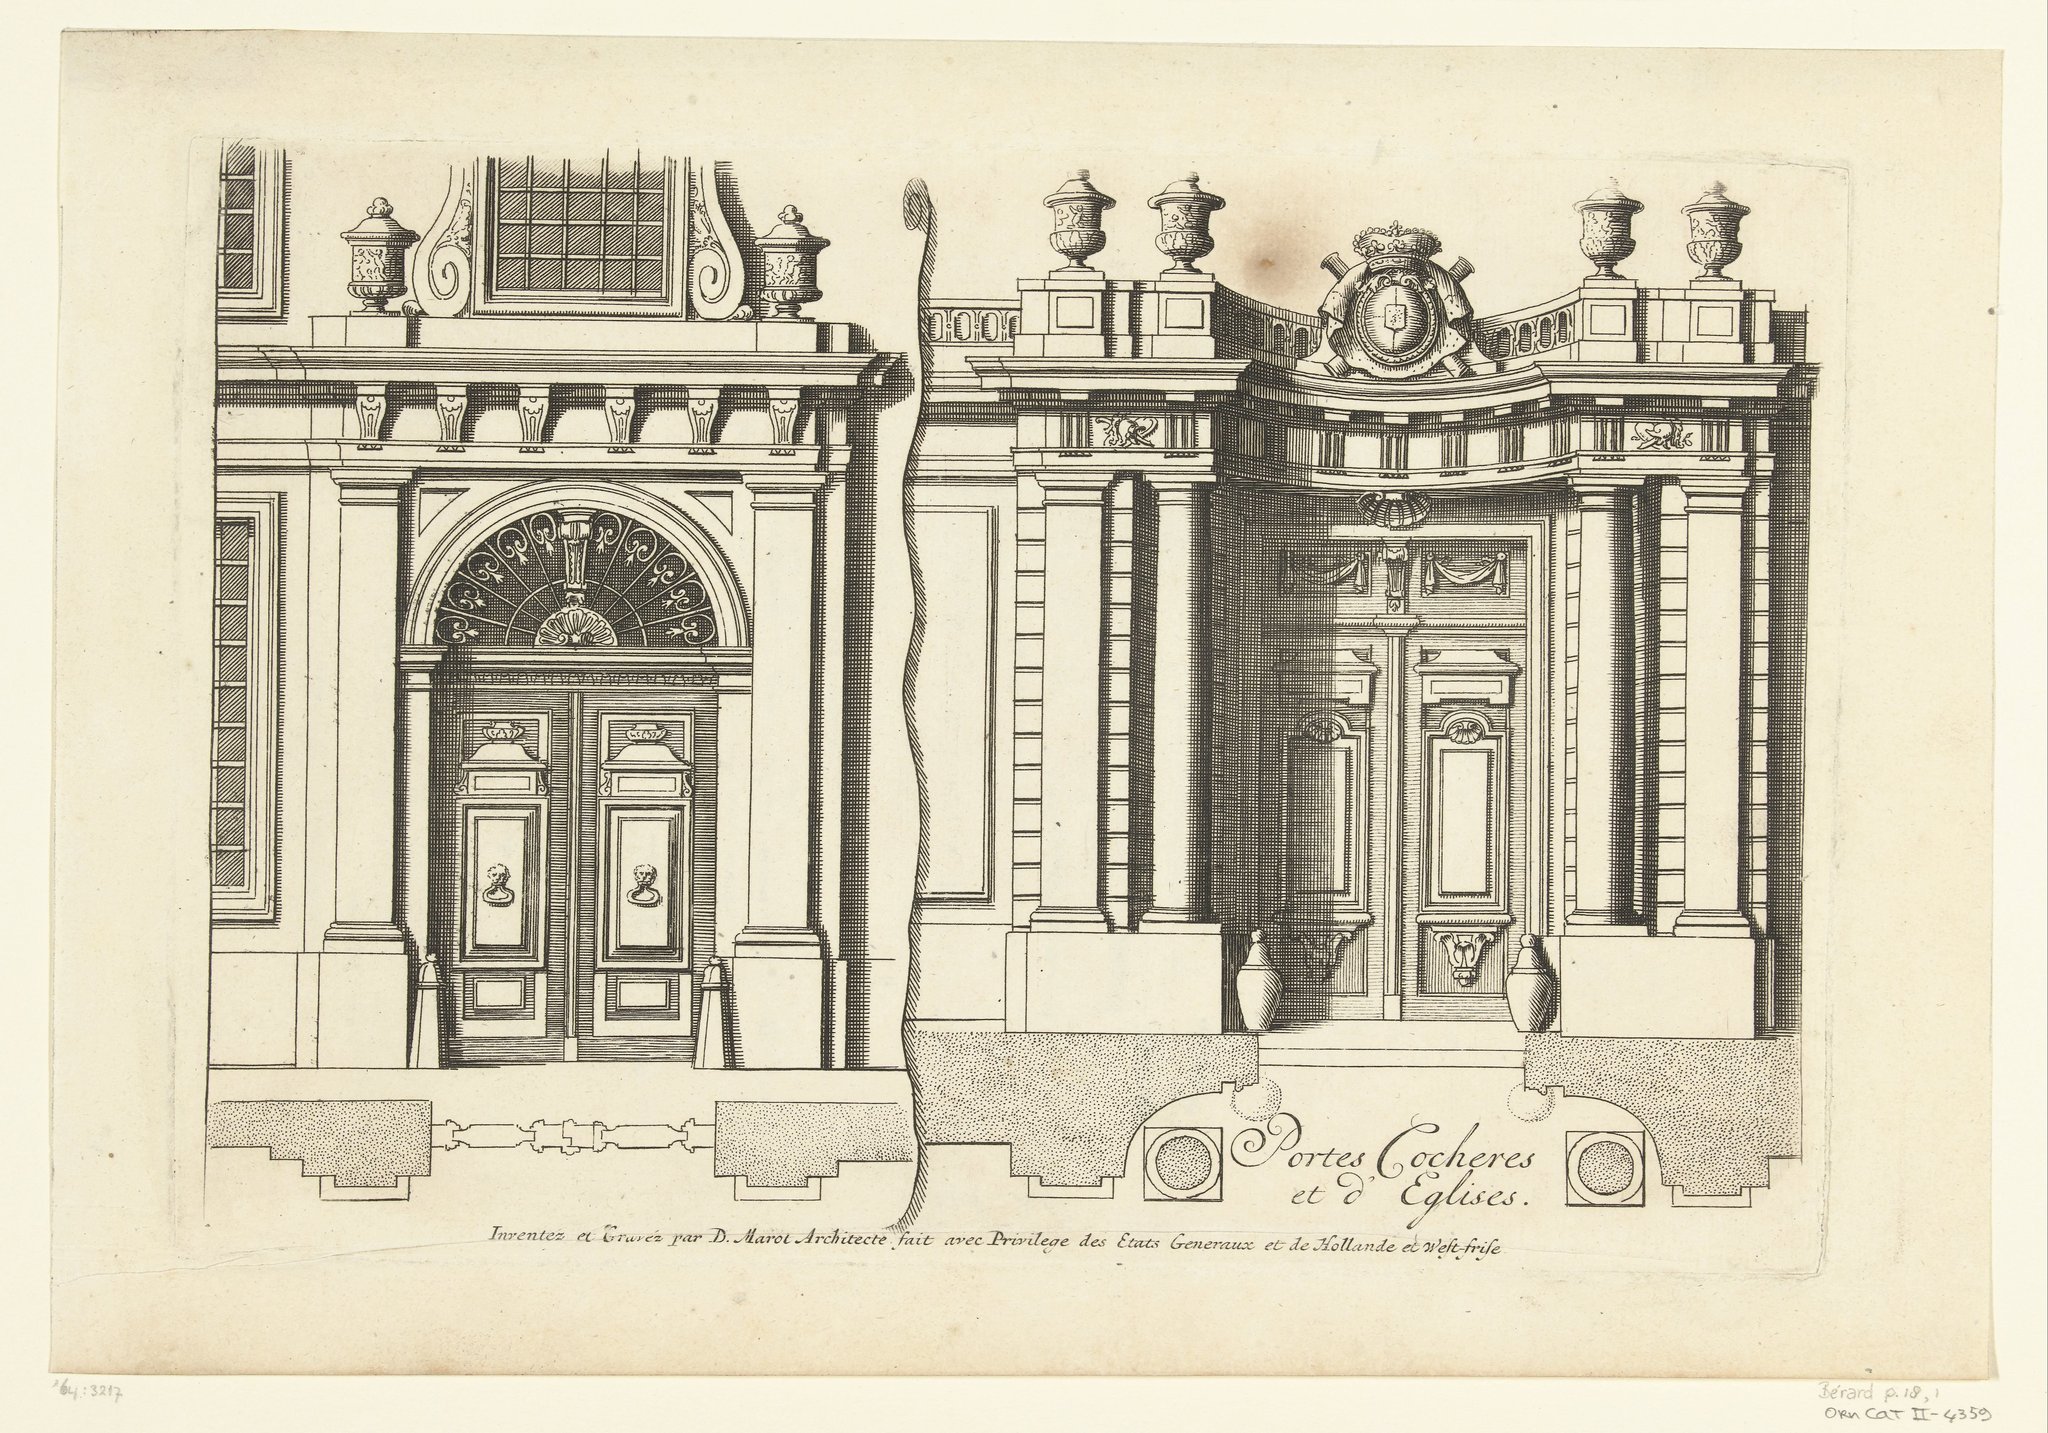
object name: titelblad, titelpagina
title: Portes Cocheres et d'Eglises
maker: daniël marot (i)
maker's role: draughtsman, print maker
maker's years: 1661-1752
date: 1673-1752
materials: paper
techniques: etching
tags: balustrade, door, parts of church exterior and annexes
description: Het portiek van het binnenhof rechts is bekroond met een wapenschild en vazen. Onder de poorten staat het plan afgebeeld. Titelblad uit serie van 6 bladen.